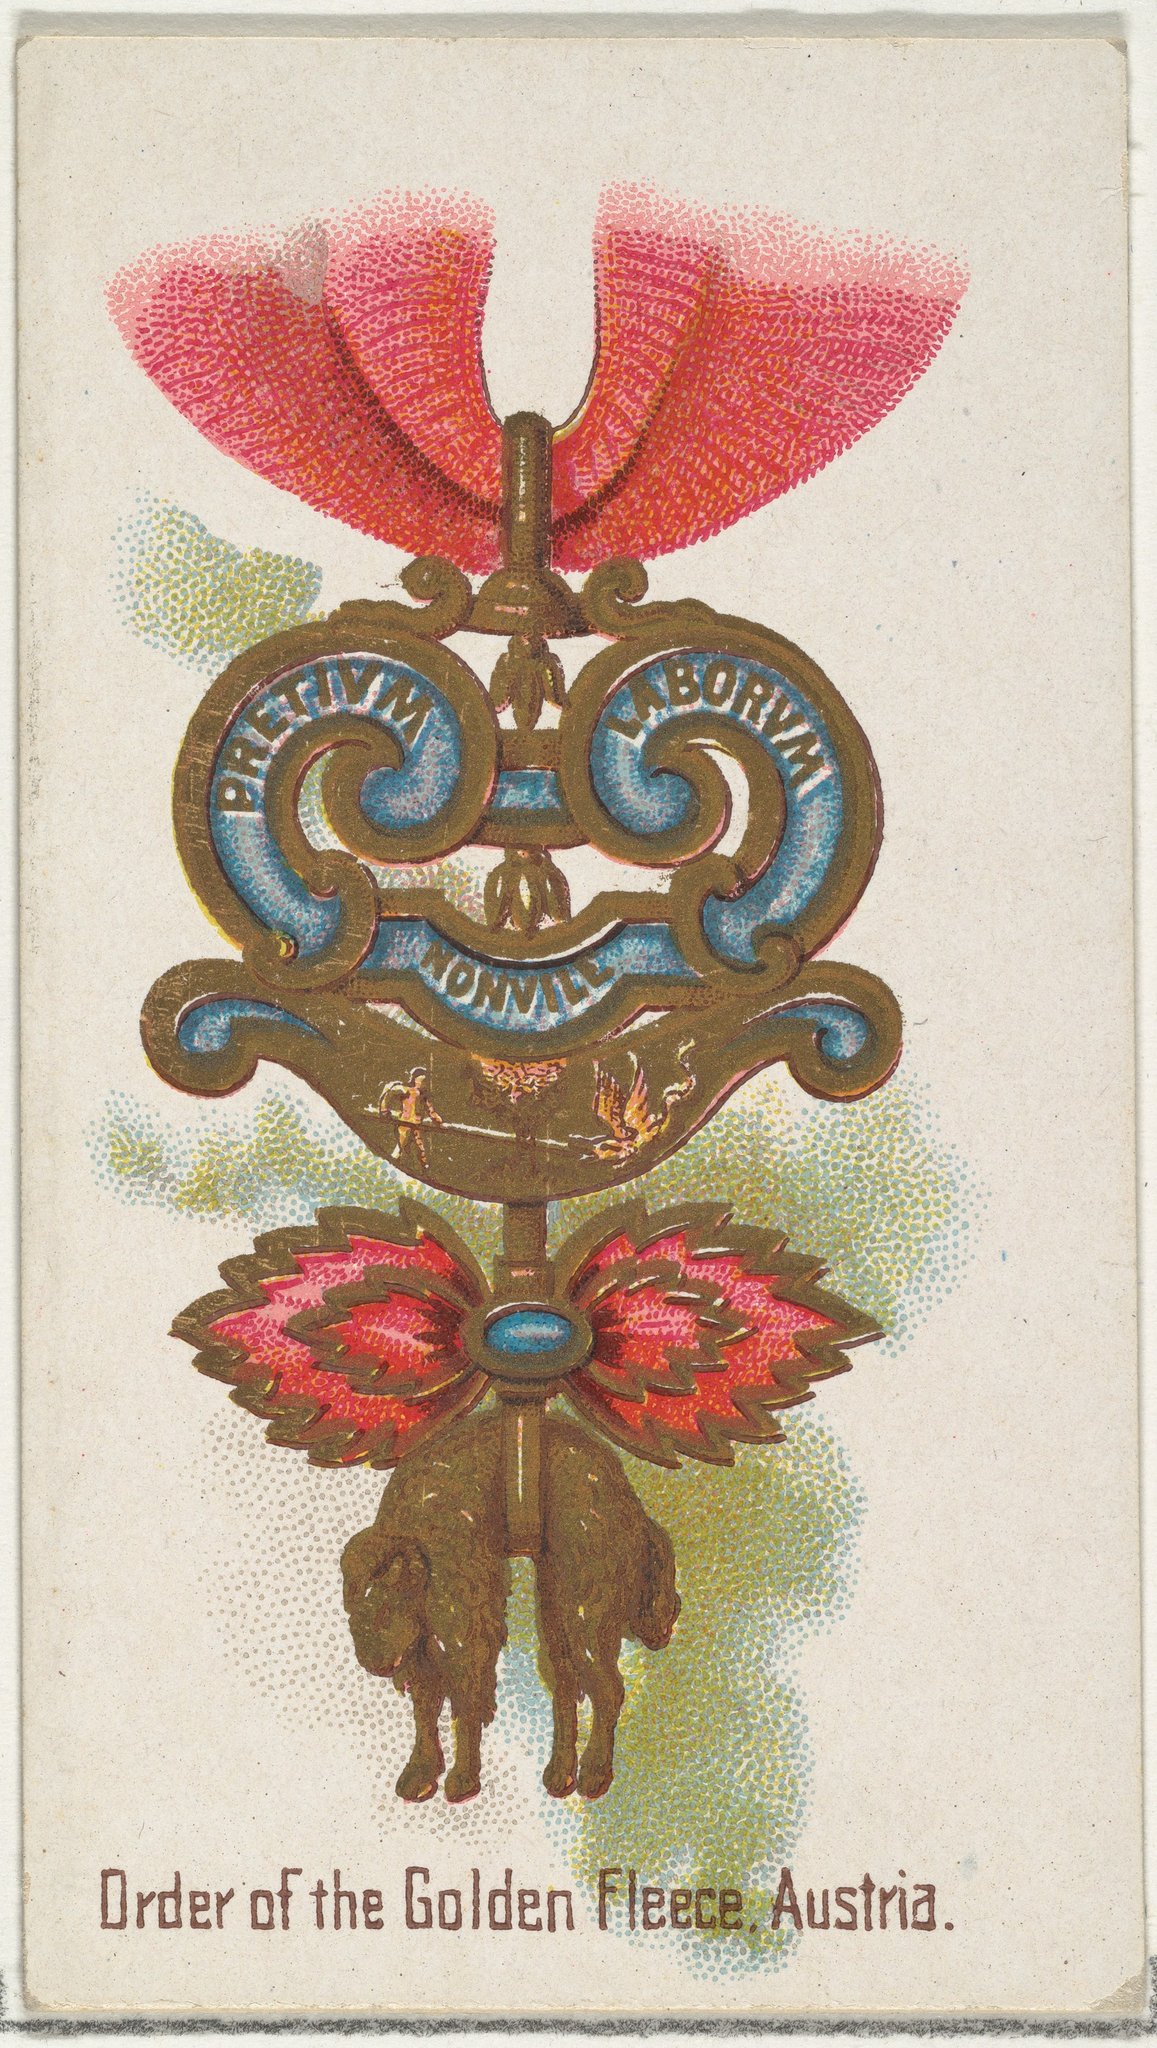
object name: print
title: Order of the Golden Fleece, Austria, from the World's Decorations series (N30) for Allen & Ginter Cigarettes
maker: allen & ginter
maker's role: publisher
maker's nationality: american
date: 1890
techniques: color lithograph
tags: medals